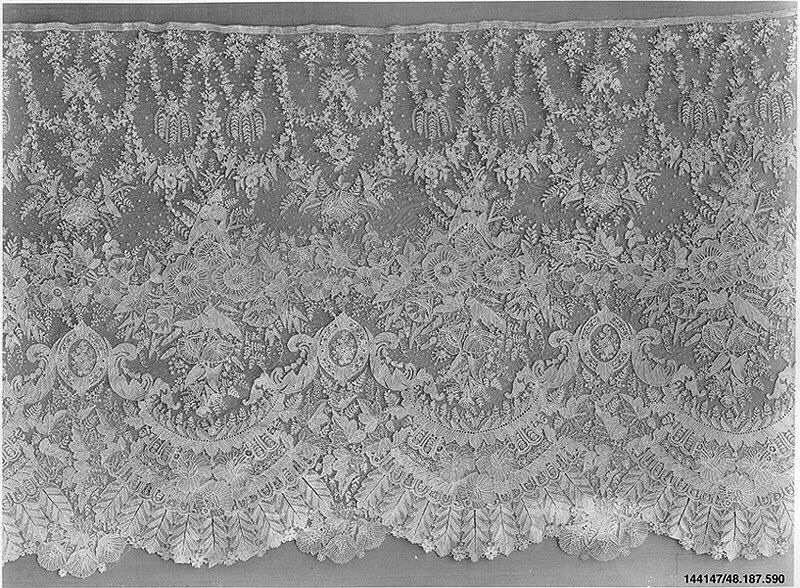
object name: flounce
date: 1851-1900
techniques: lace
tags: flowers